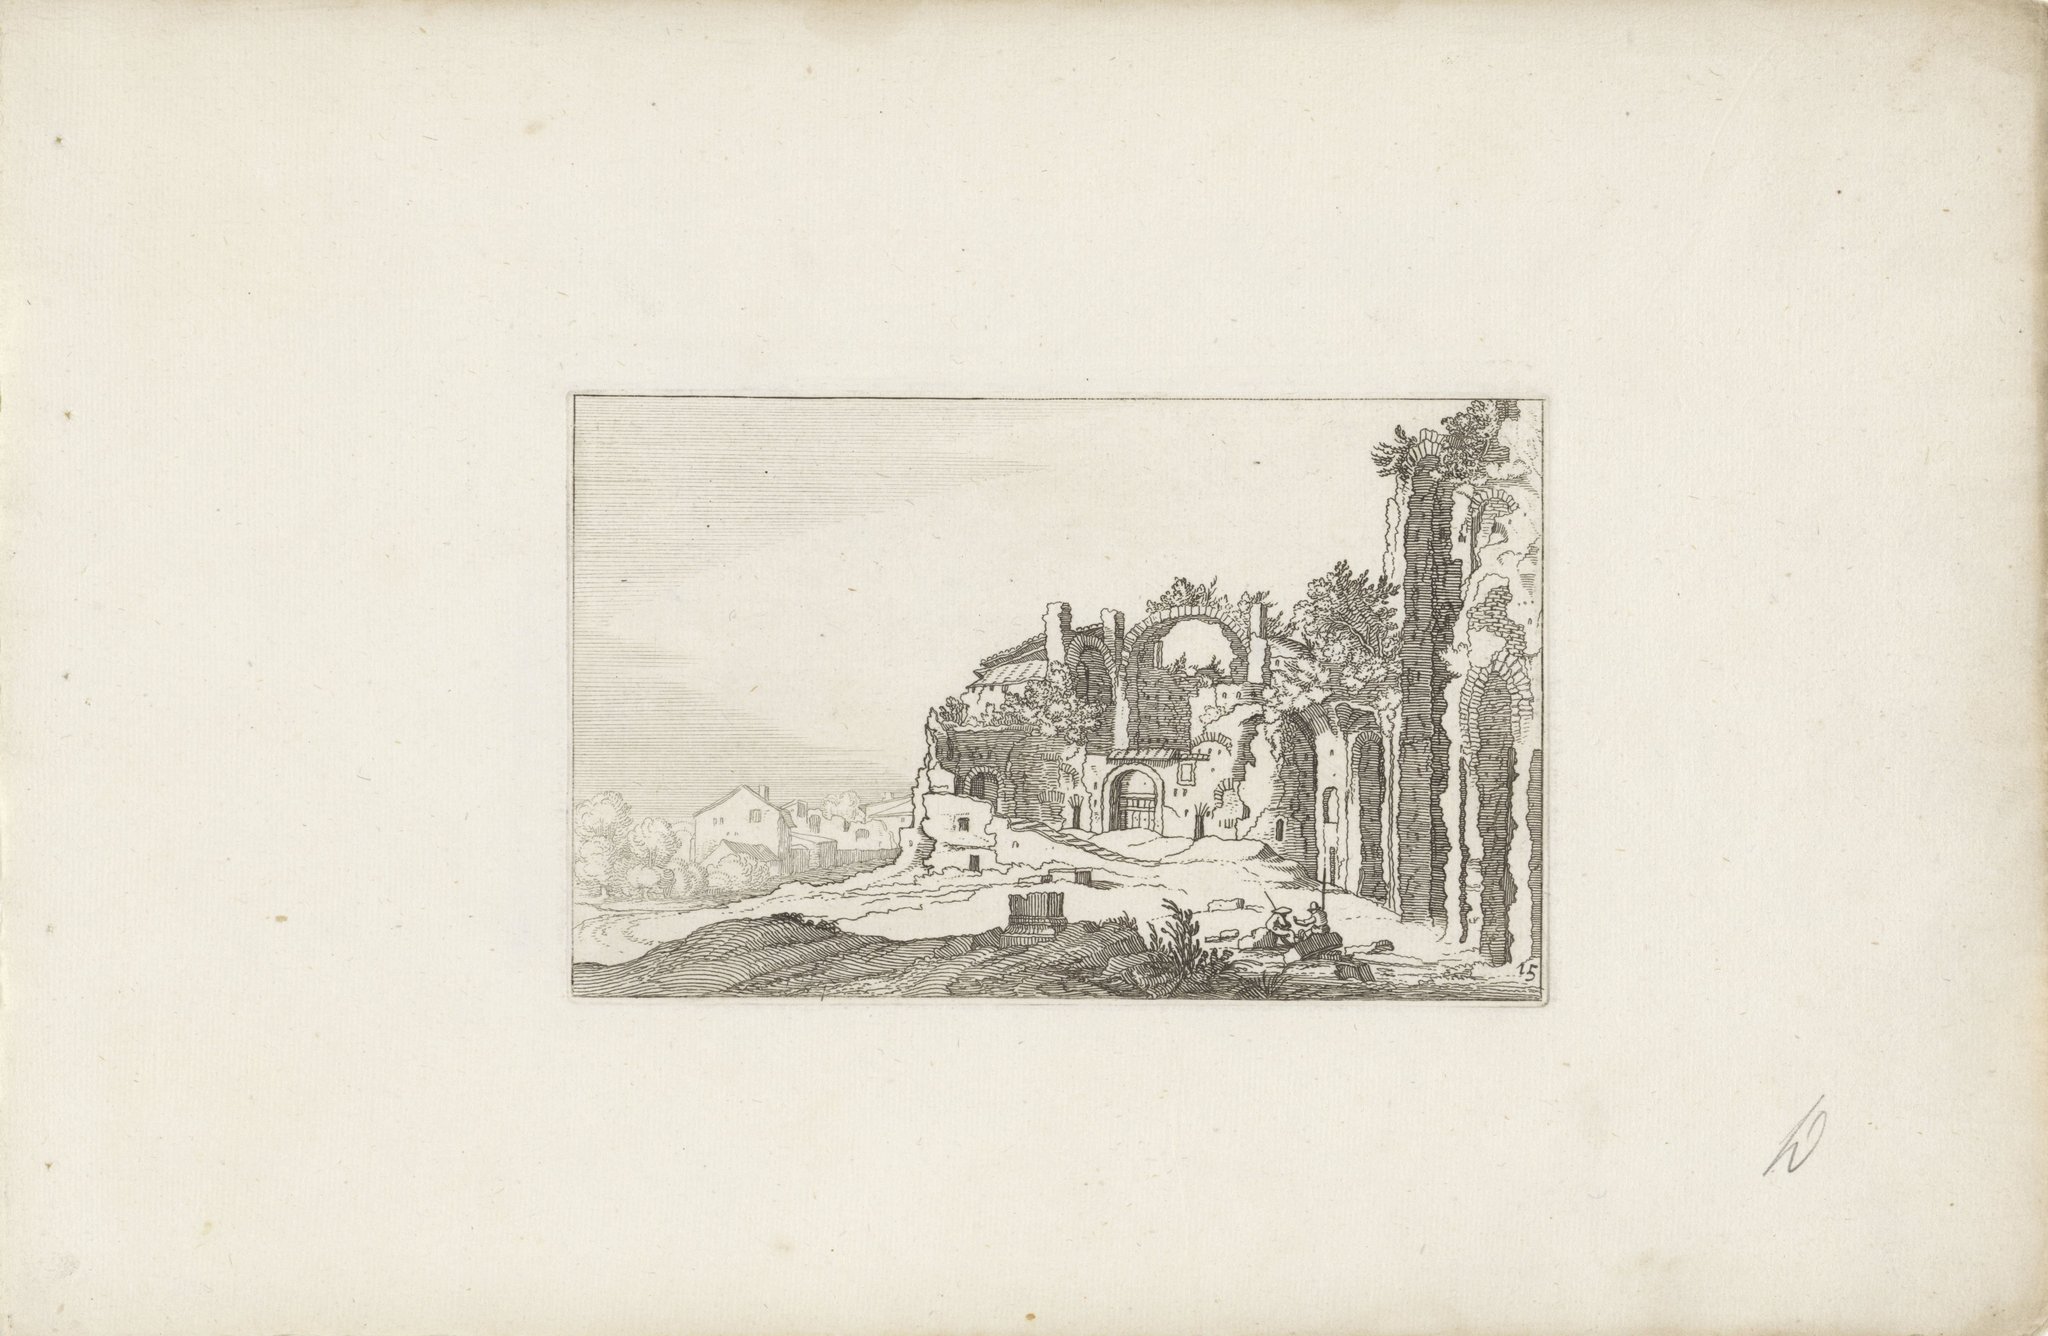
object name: print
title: Italiaanse landschappen met ruïnes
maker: claes jansz. visscher (ii)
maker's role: draughtsman, print maker, publisher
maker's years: 1586-1652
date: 1618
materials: paper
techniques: etching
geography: amsterdam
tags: public baths, conversation, dialogue; conversation piece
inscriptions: collector's mark: Lugt 2233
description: Glooiend landschap met rechts de thermen van Diocletianus, te Rome. Voor de termen voeren twee mannen een gesprek.